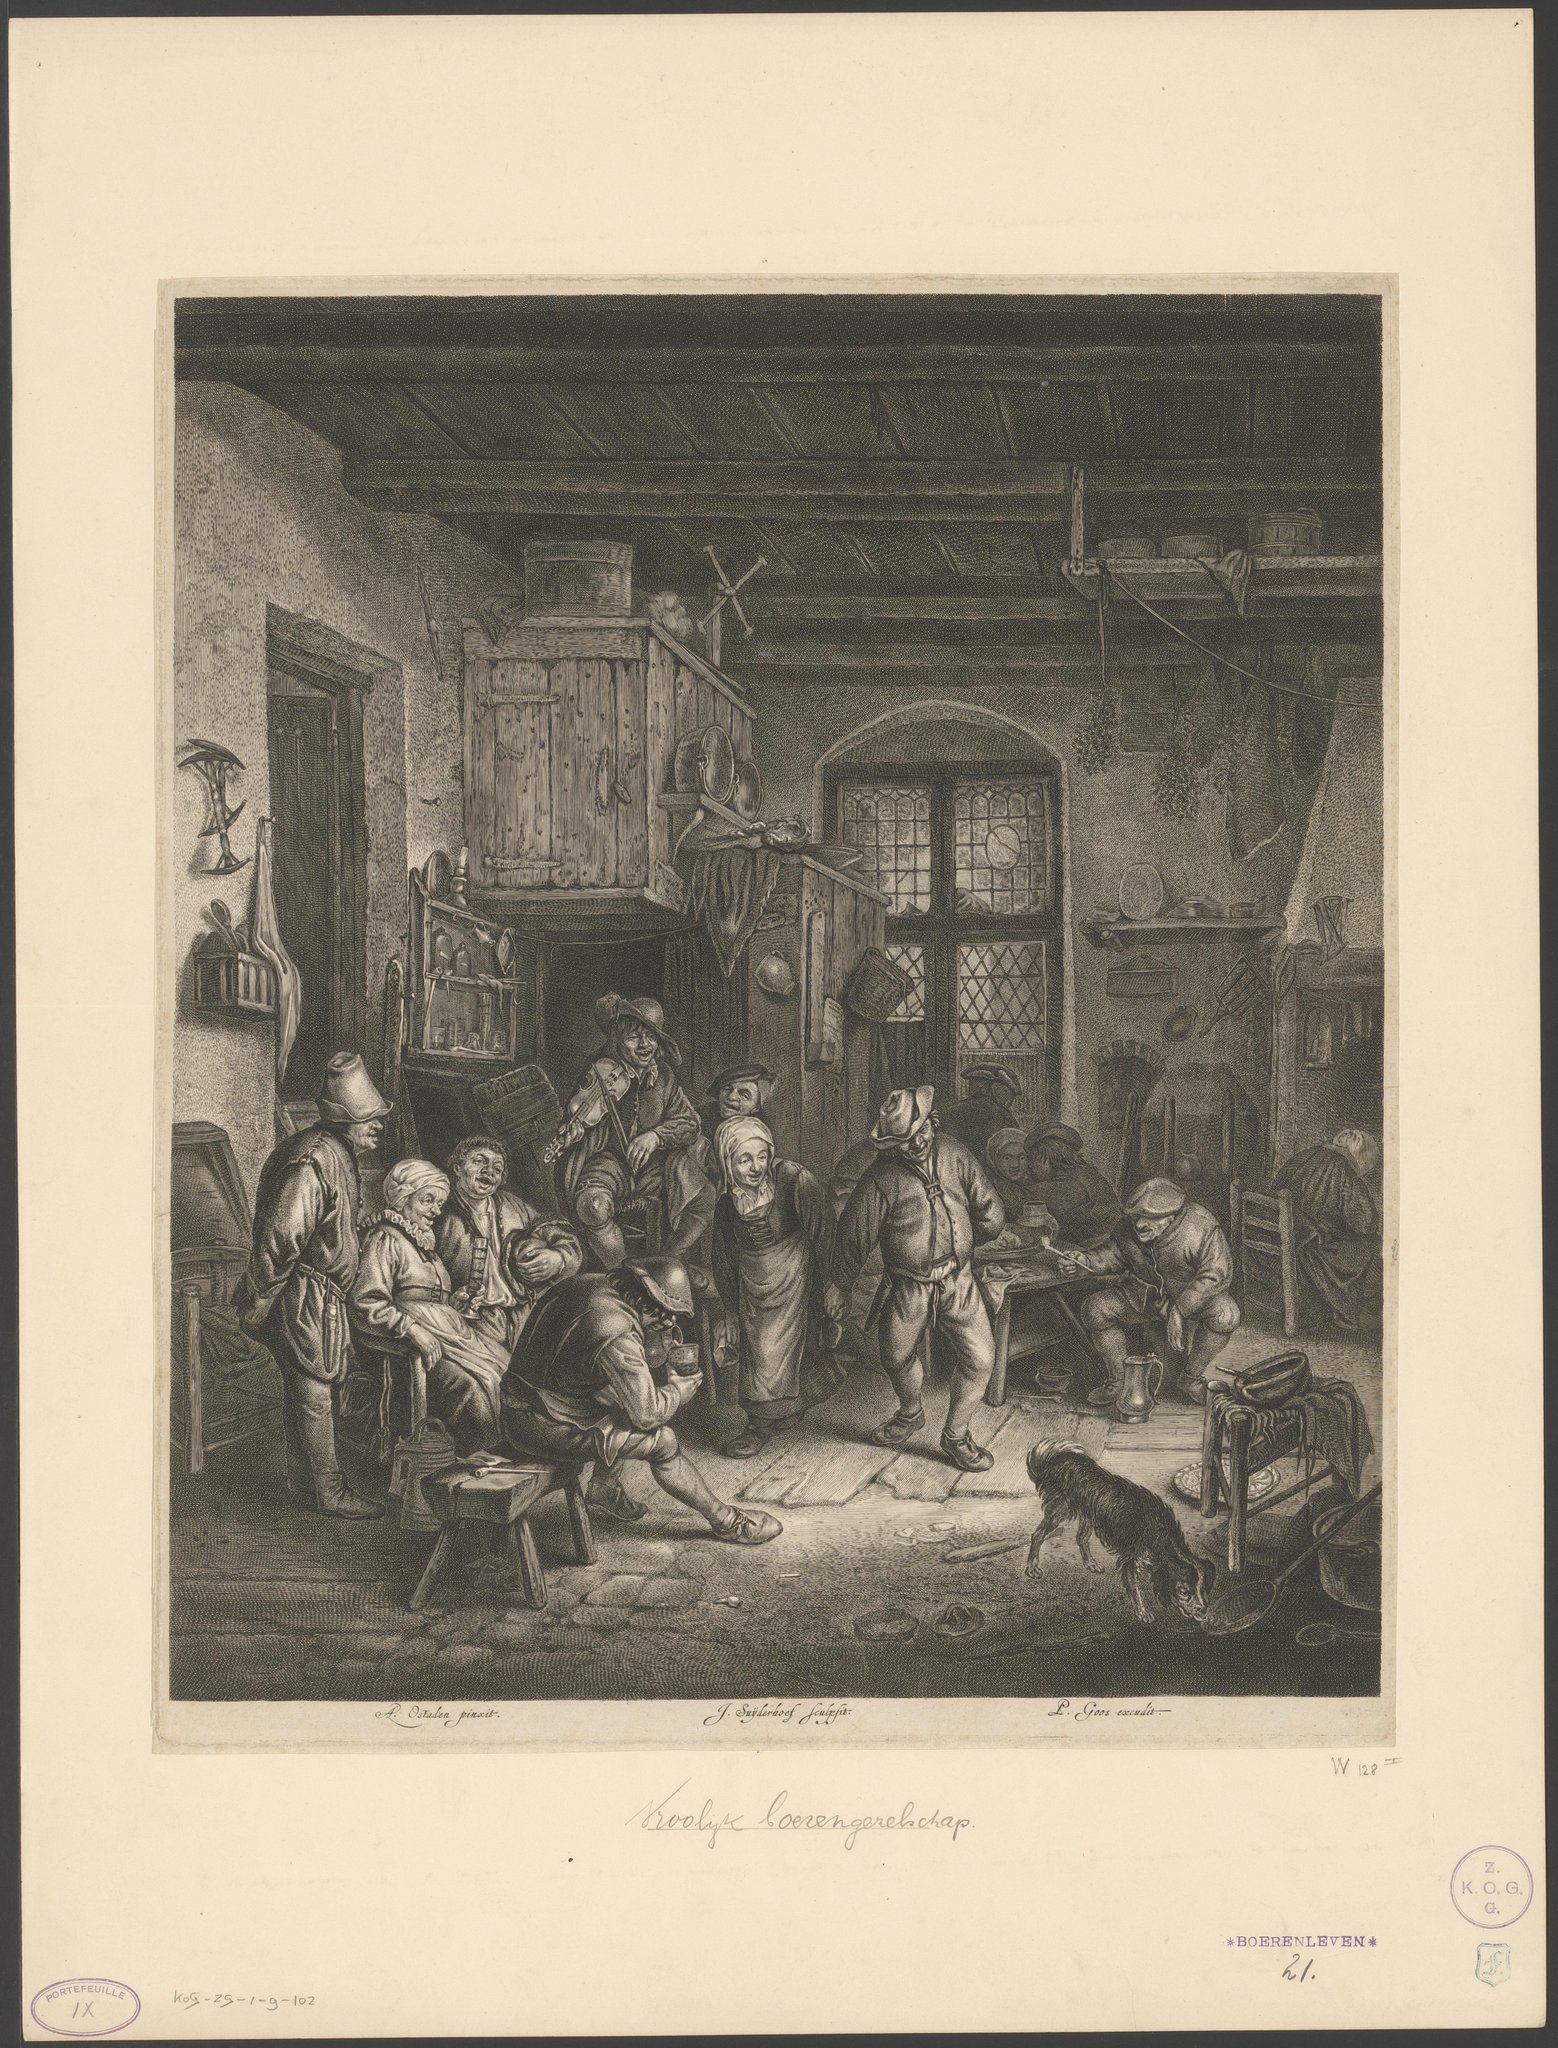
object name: print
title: Boereninterieur met dansend paar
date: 1657-1672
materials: paper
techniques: engraving, etching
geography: amsterdam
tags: inn, coffee-house, public house, etc., violin, fiddle, pipe ~ tobacco, open hearth, fire-place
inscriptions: collector's mark: Lugt 963, stamp, collector's mark: Lugt 1641, stamp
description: In een herberginterieur maken een oude vrouw en een oude man hand in hand een dansje. Links van hen een vioolspeler en zingende en drinkende mensen. Rechts een zittende man met een pijp in zijn hand. Rechts op de voorgrond een hond. Onderwerpsrubrieken binnen de Atlas Zeden en Gewoonten: Handel, nijverheid en verkeer, Boerenleven.